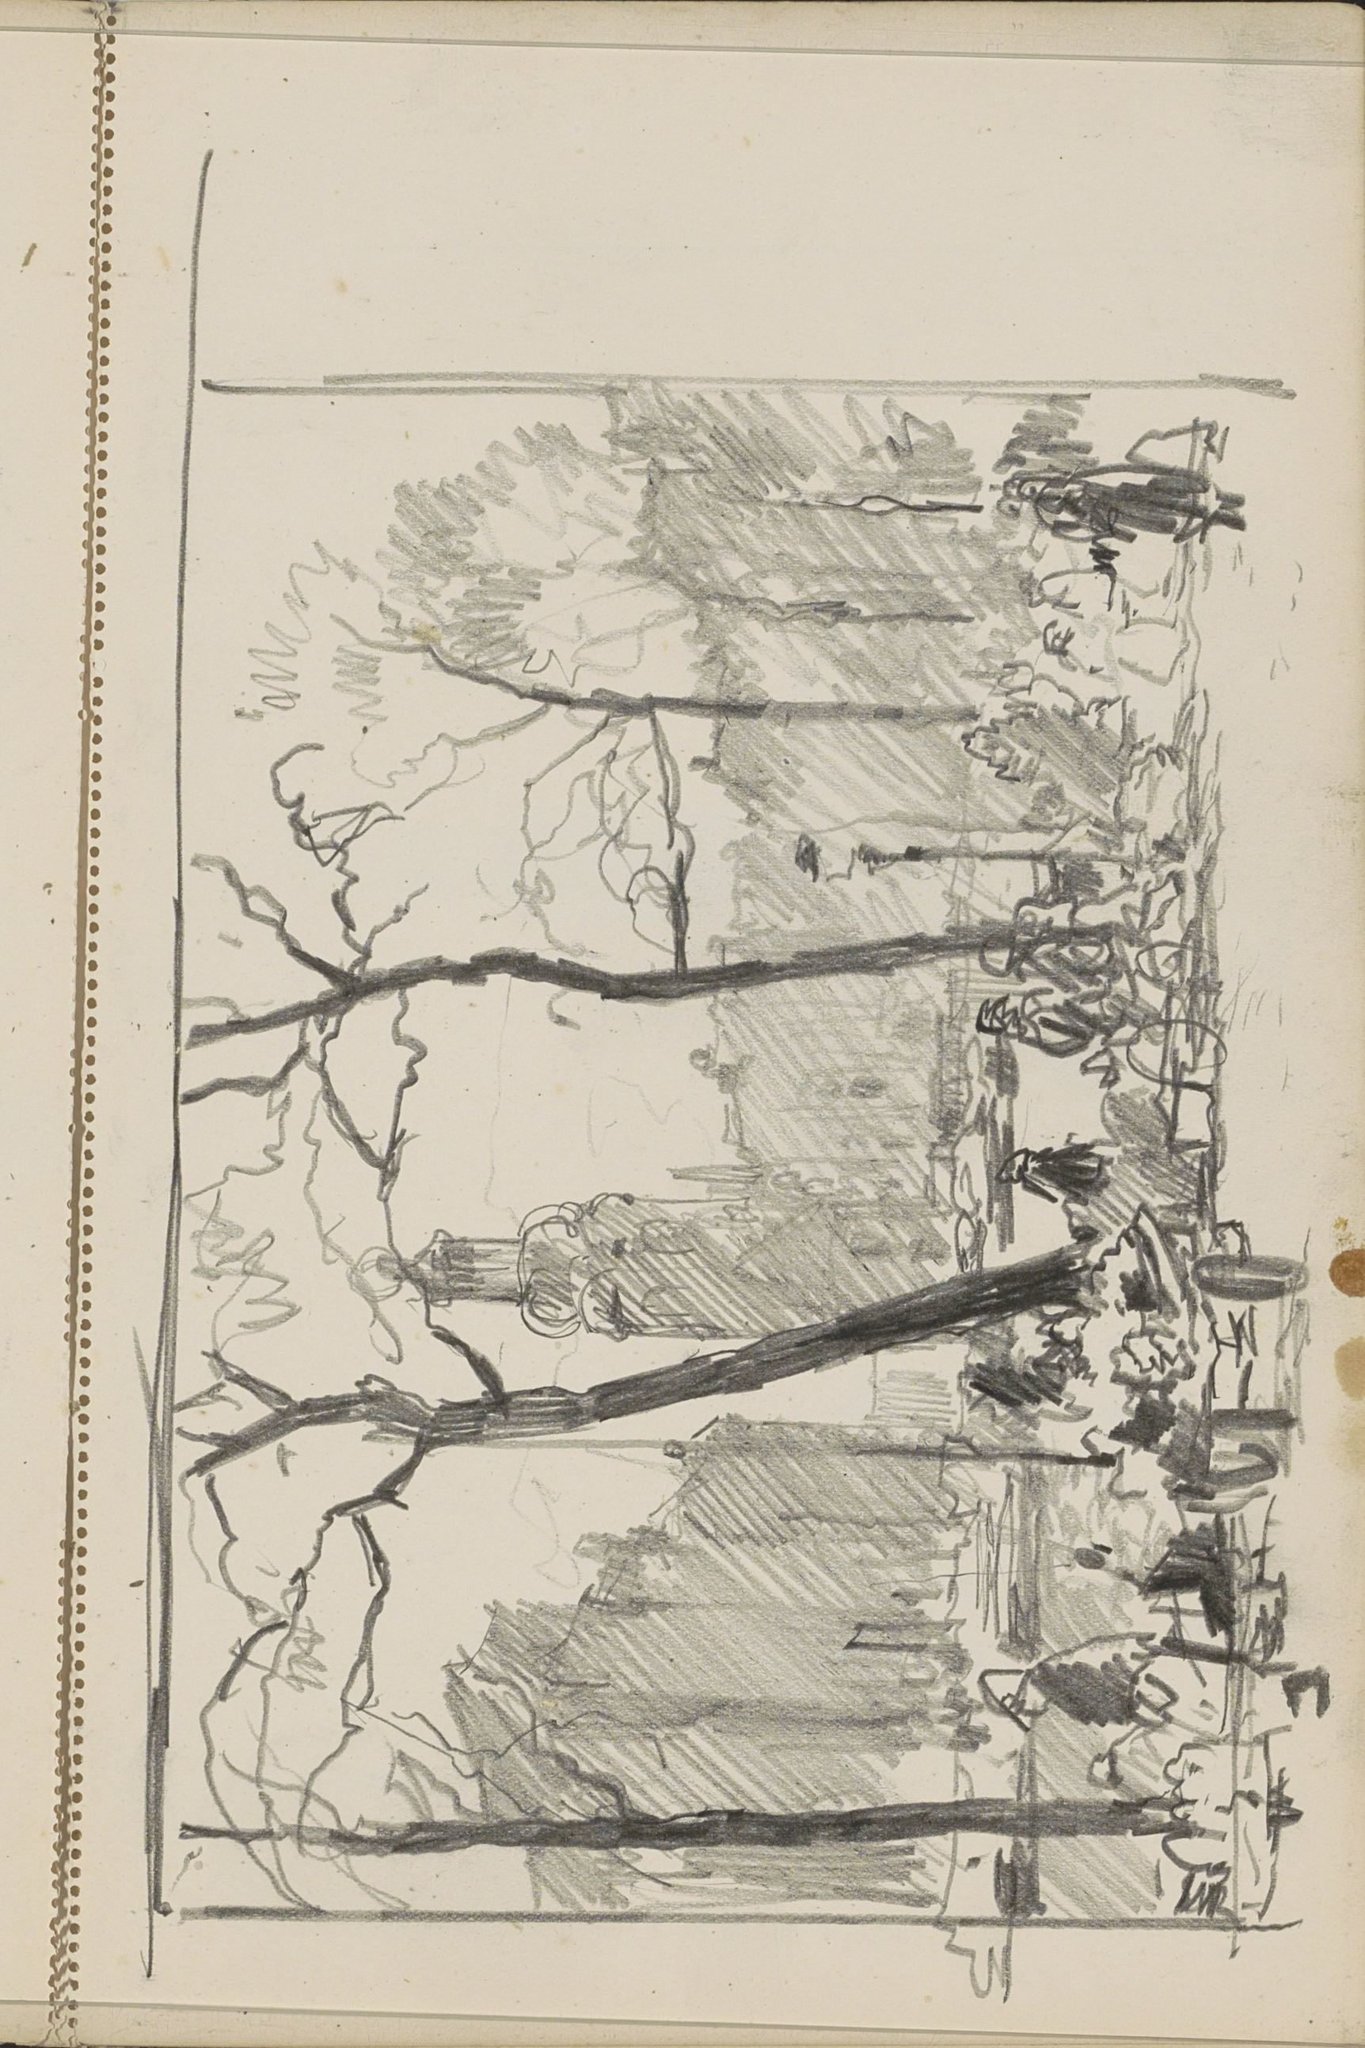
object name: sketchbook leaf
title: Figuren op een pad langs een gracht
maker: cornelis vreedenburgh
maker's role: draughtsman, print maker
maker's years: 1880-1946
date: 1890-1946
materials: paper, pencil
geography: amsterdam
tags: canals, waters (in city), street (+ city(-scape) with figures, staffage), amsterdam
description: Op de achtergrond een toren, mogelijk de Munttoren te Amsterdam. Blad 48 recto uit een schetsboek met 59 bladen.